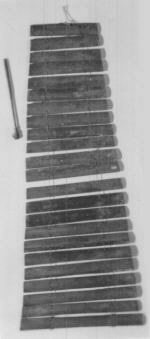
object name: valimba xylophone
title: valimba (xylophone)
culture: sena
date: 1801-1900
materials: leather, wood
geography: zimbabwe